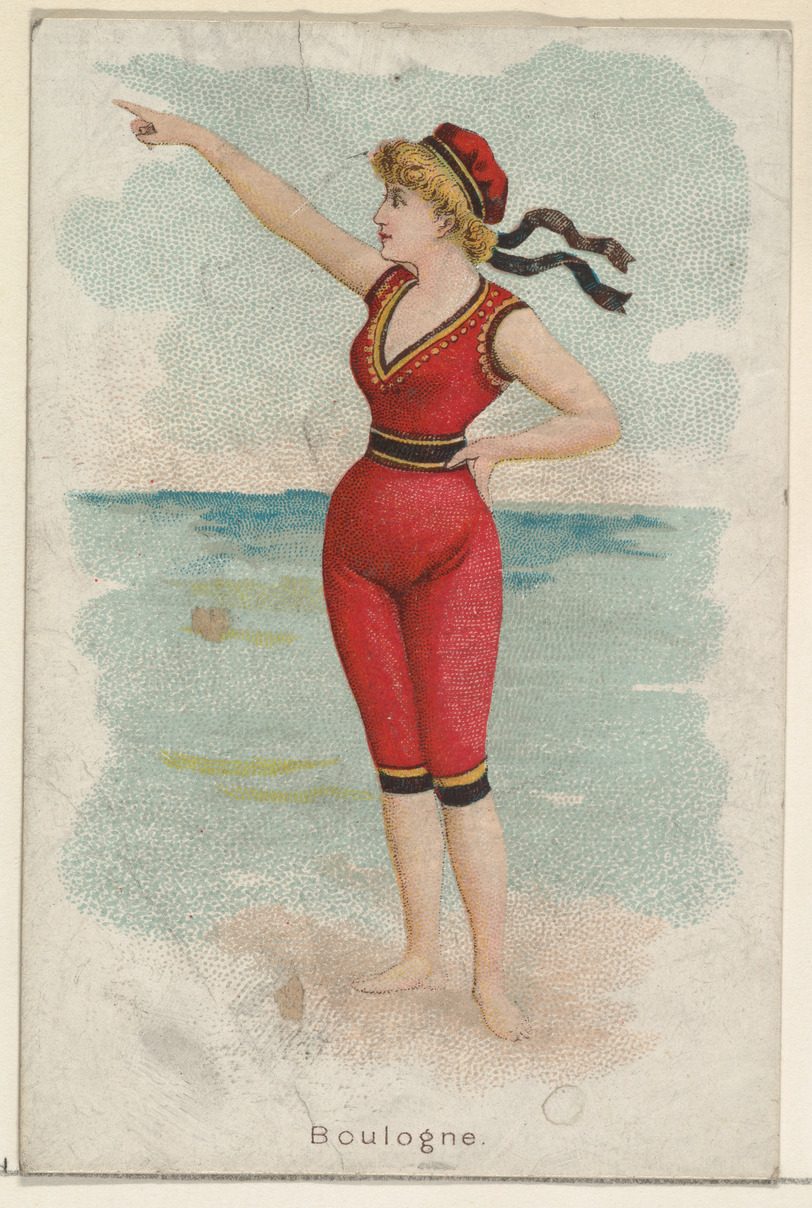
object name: print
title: Boulogne, from the Beautiful Bathers series (N192) issued by Wm. S. Kimball & Co.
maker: william s. kimball & company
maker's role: publisher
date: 1889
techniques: color lithograph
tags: profiles,women